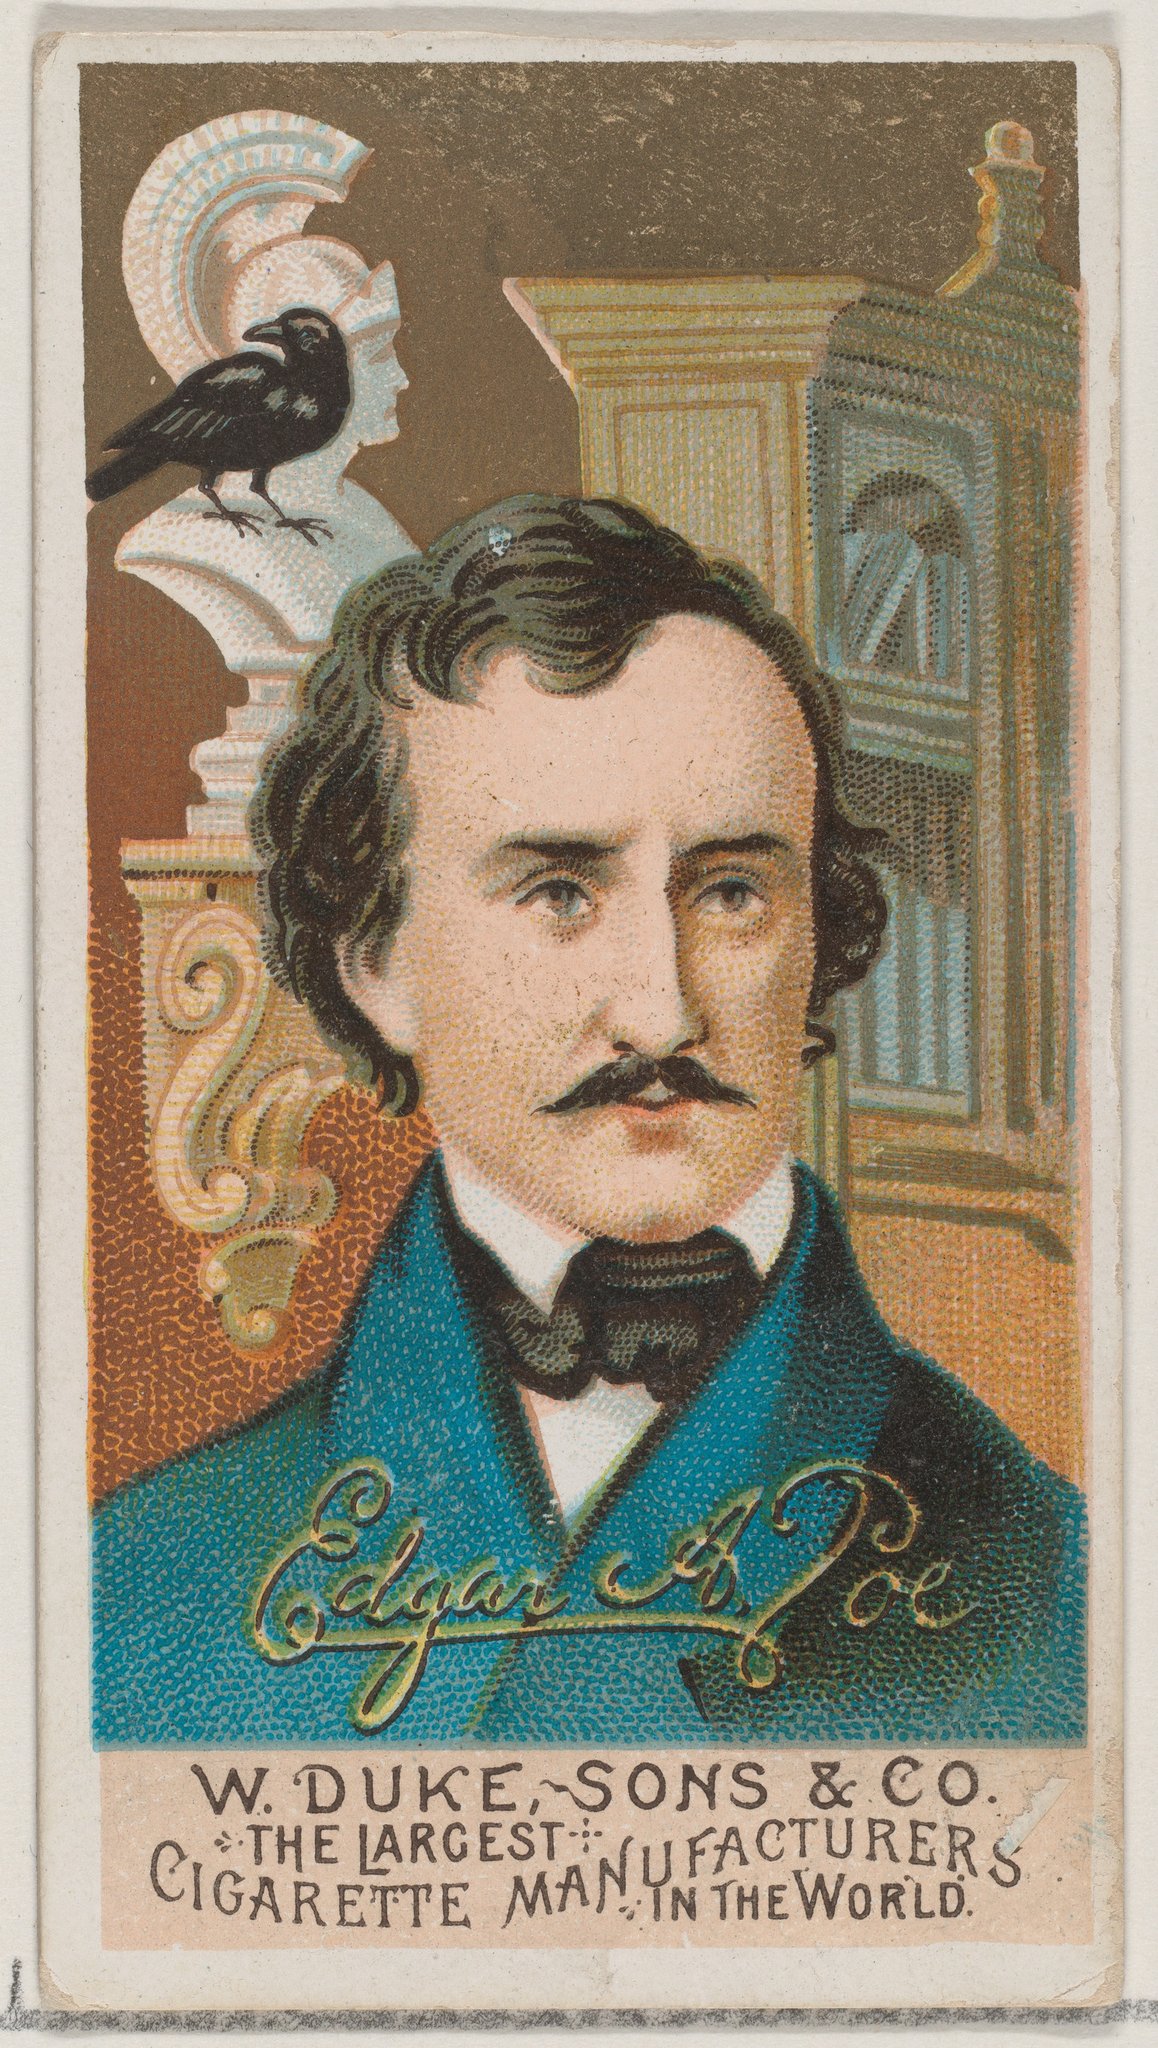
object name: print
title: Edgar Allan Poe, from the series Great Americans (N76) for Duke brand cigarettes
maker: w. duke, sons & co.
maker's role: publisher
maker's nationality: american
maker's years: 1870-1920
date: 1888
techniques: color lithograph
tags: men